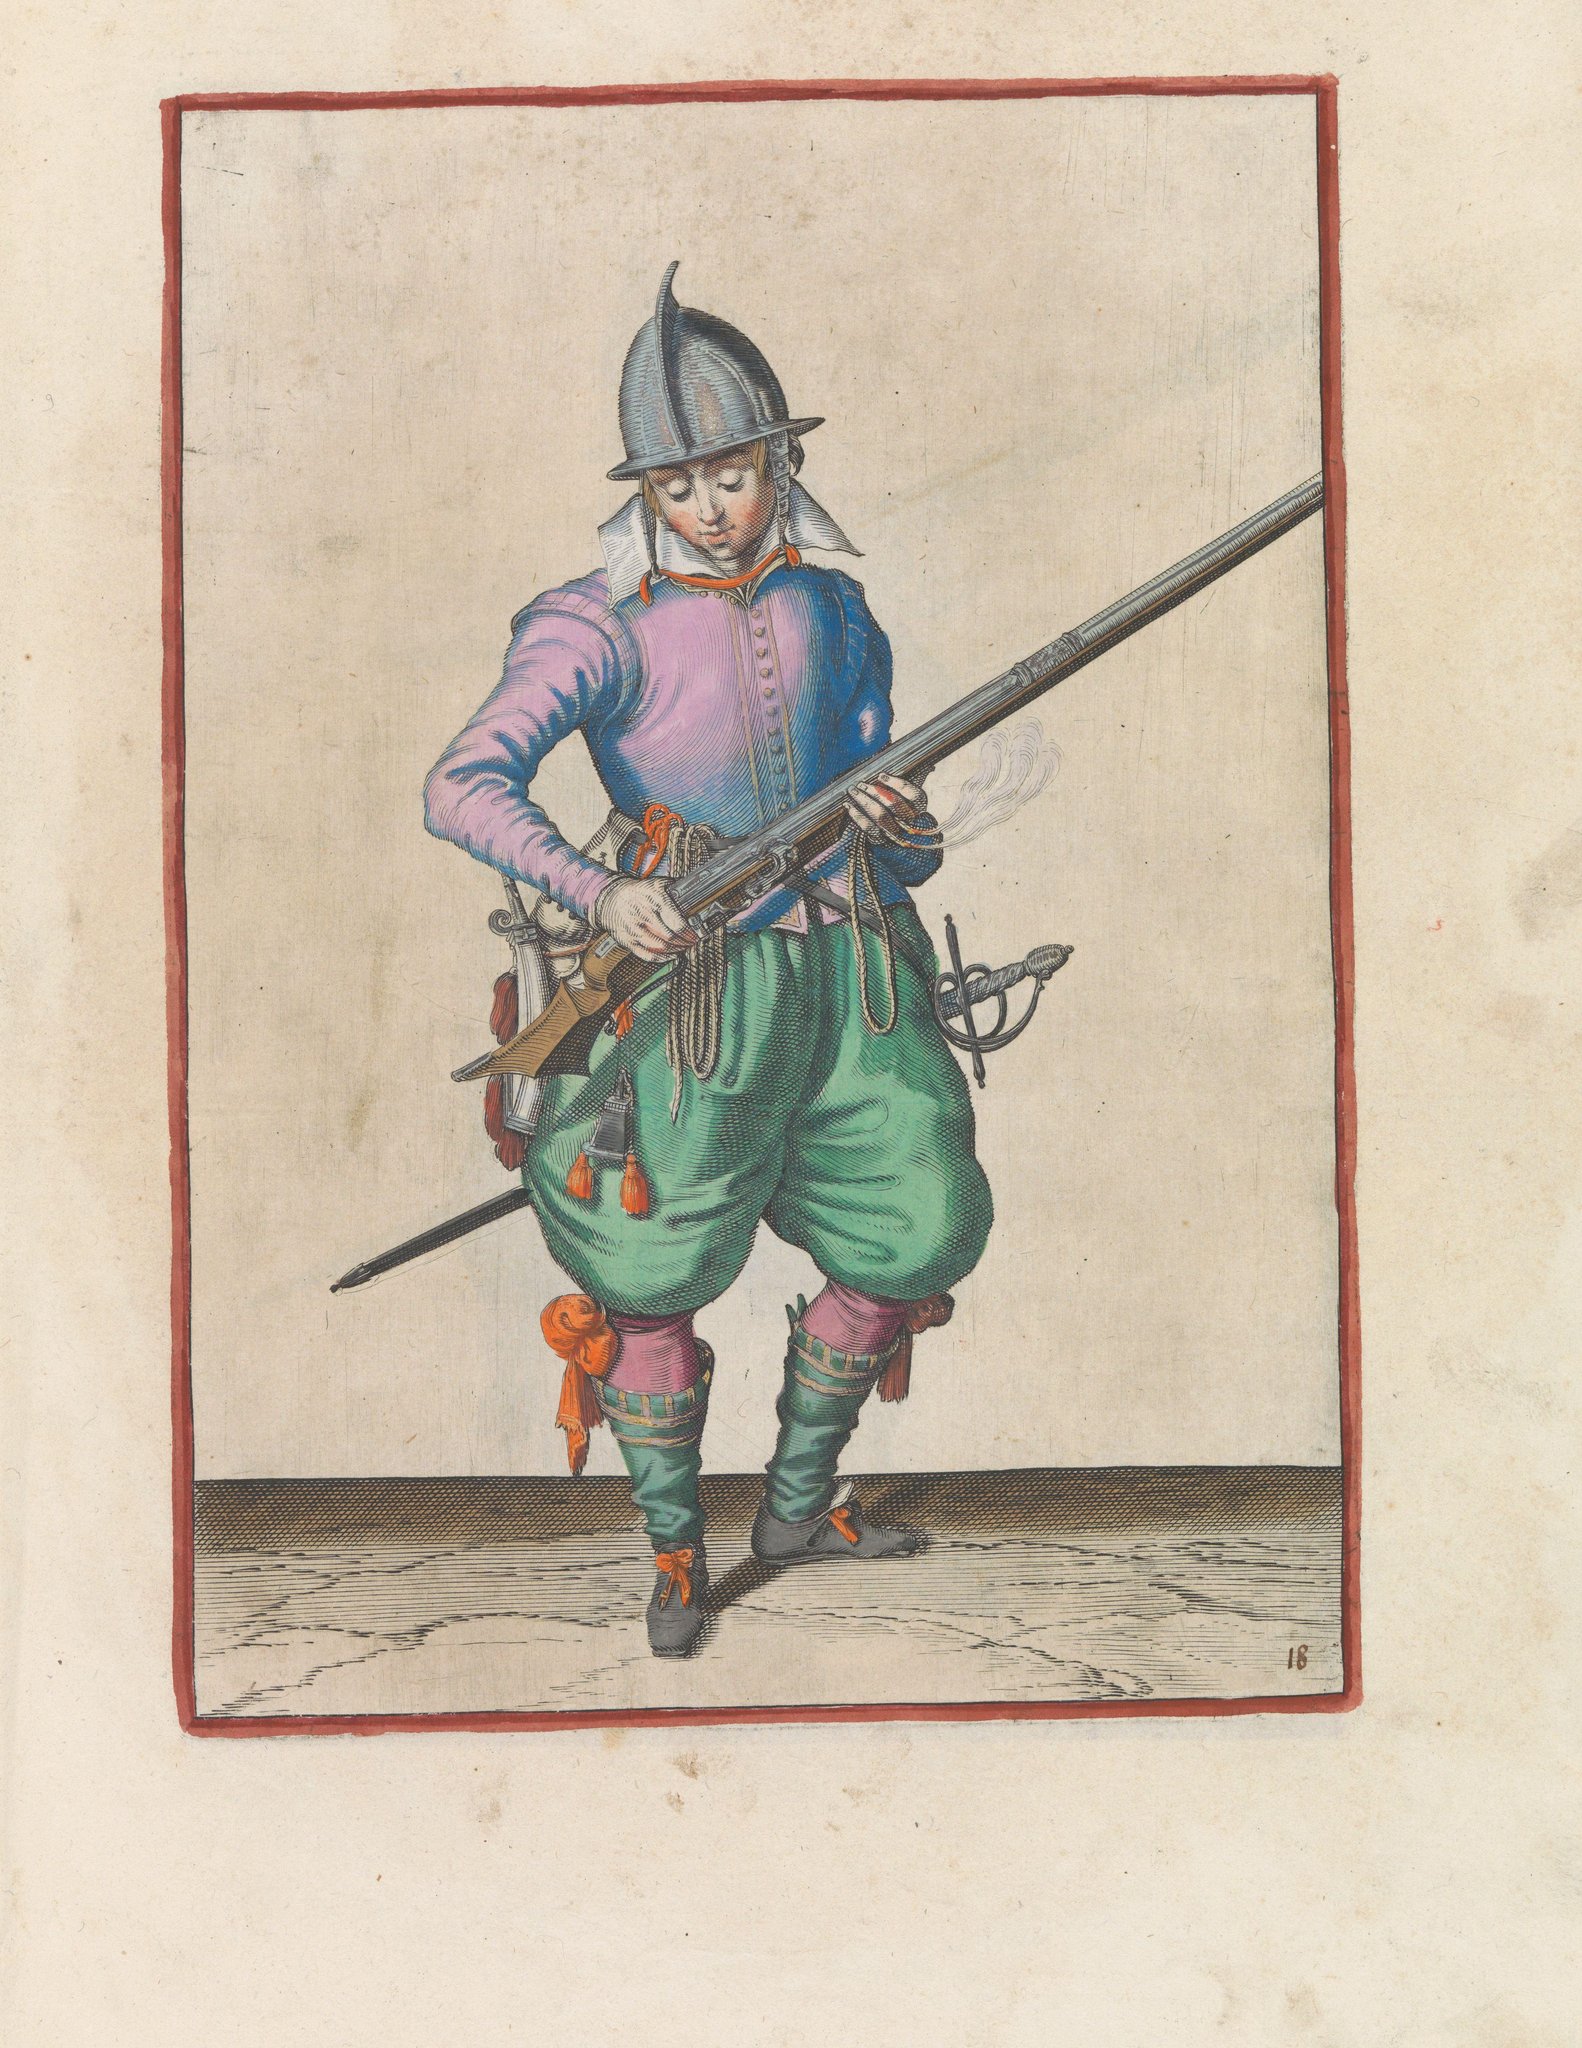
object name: print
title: Soldaat die kruit van zijn roer schudt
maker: jacques de gheyn (ii)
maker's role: painter, print maker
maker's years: 1565-1629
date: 1597-1607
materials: paper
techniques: engraving, hand coloring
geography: the hague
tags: handling of weapons ~ military training, firearms: rifle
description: Een soldaat, ten voeten uit, naar rechts, die met beide handen een roer (een bepaald type vuurwapen) schudt, om eventueel buiten de pan (het kruitreservoir) gevallen kruit ervan af te krijgen. In zijn linkerhand behalve de loop van het roer ook een brandende lont. Deze prent is onderdeel van de reeks van 42 met de hand genummerde prenten van roerschutters in de Wapenhandelinghe.